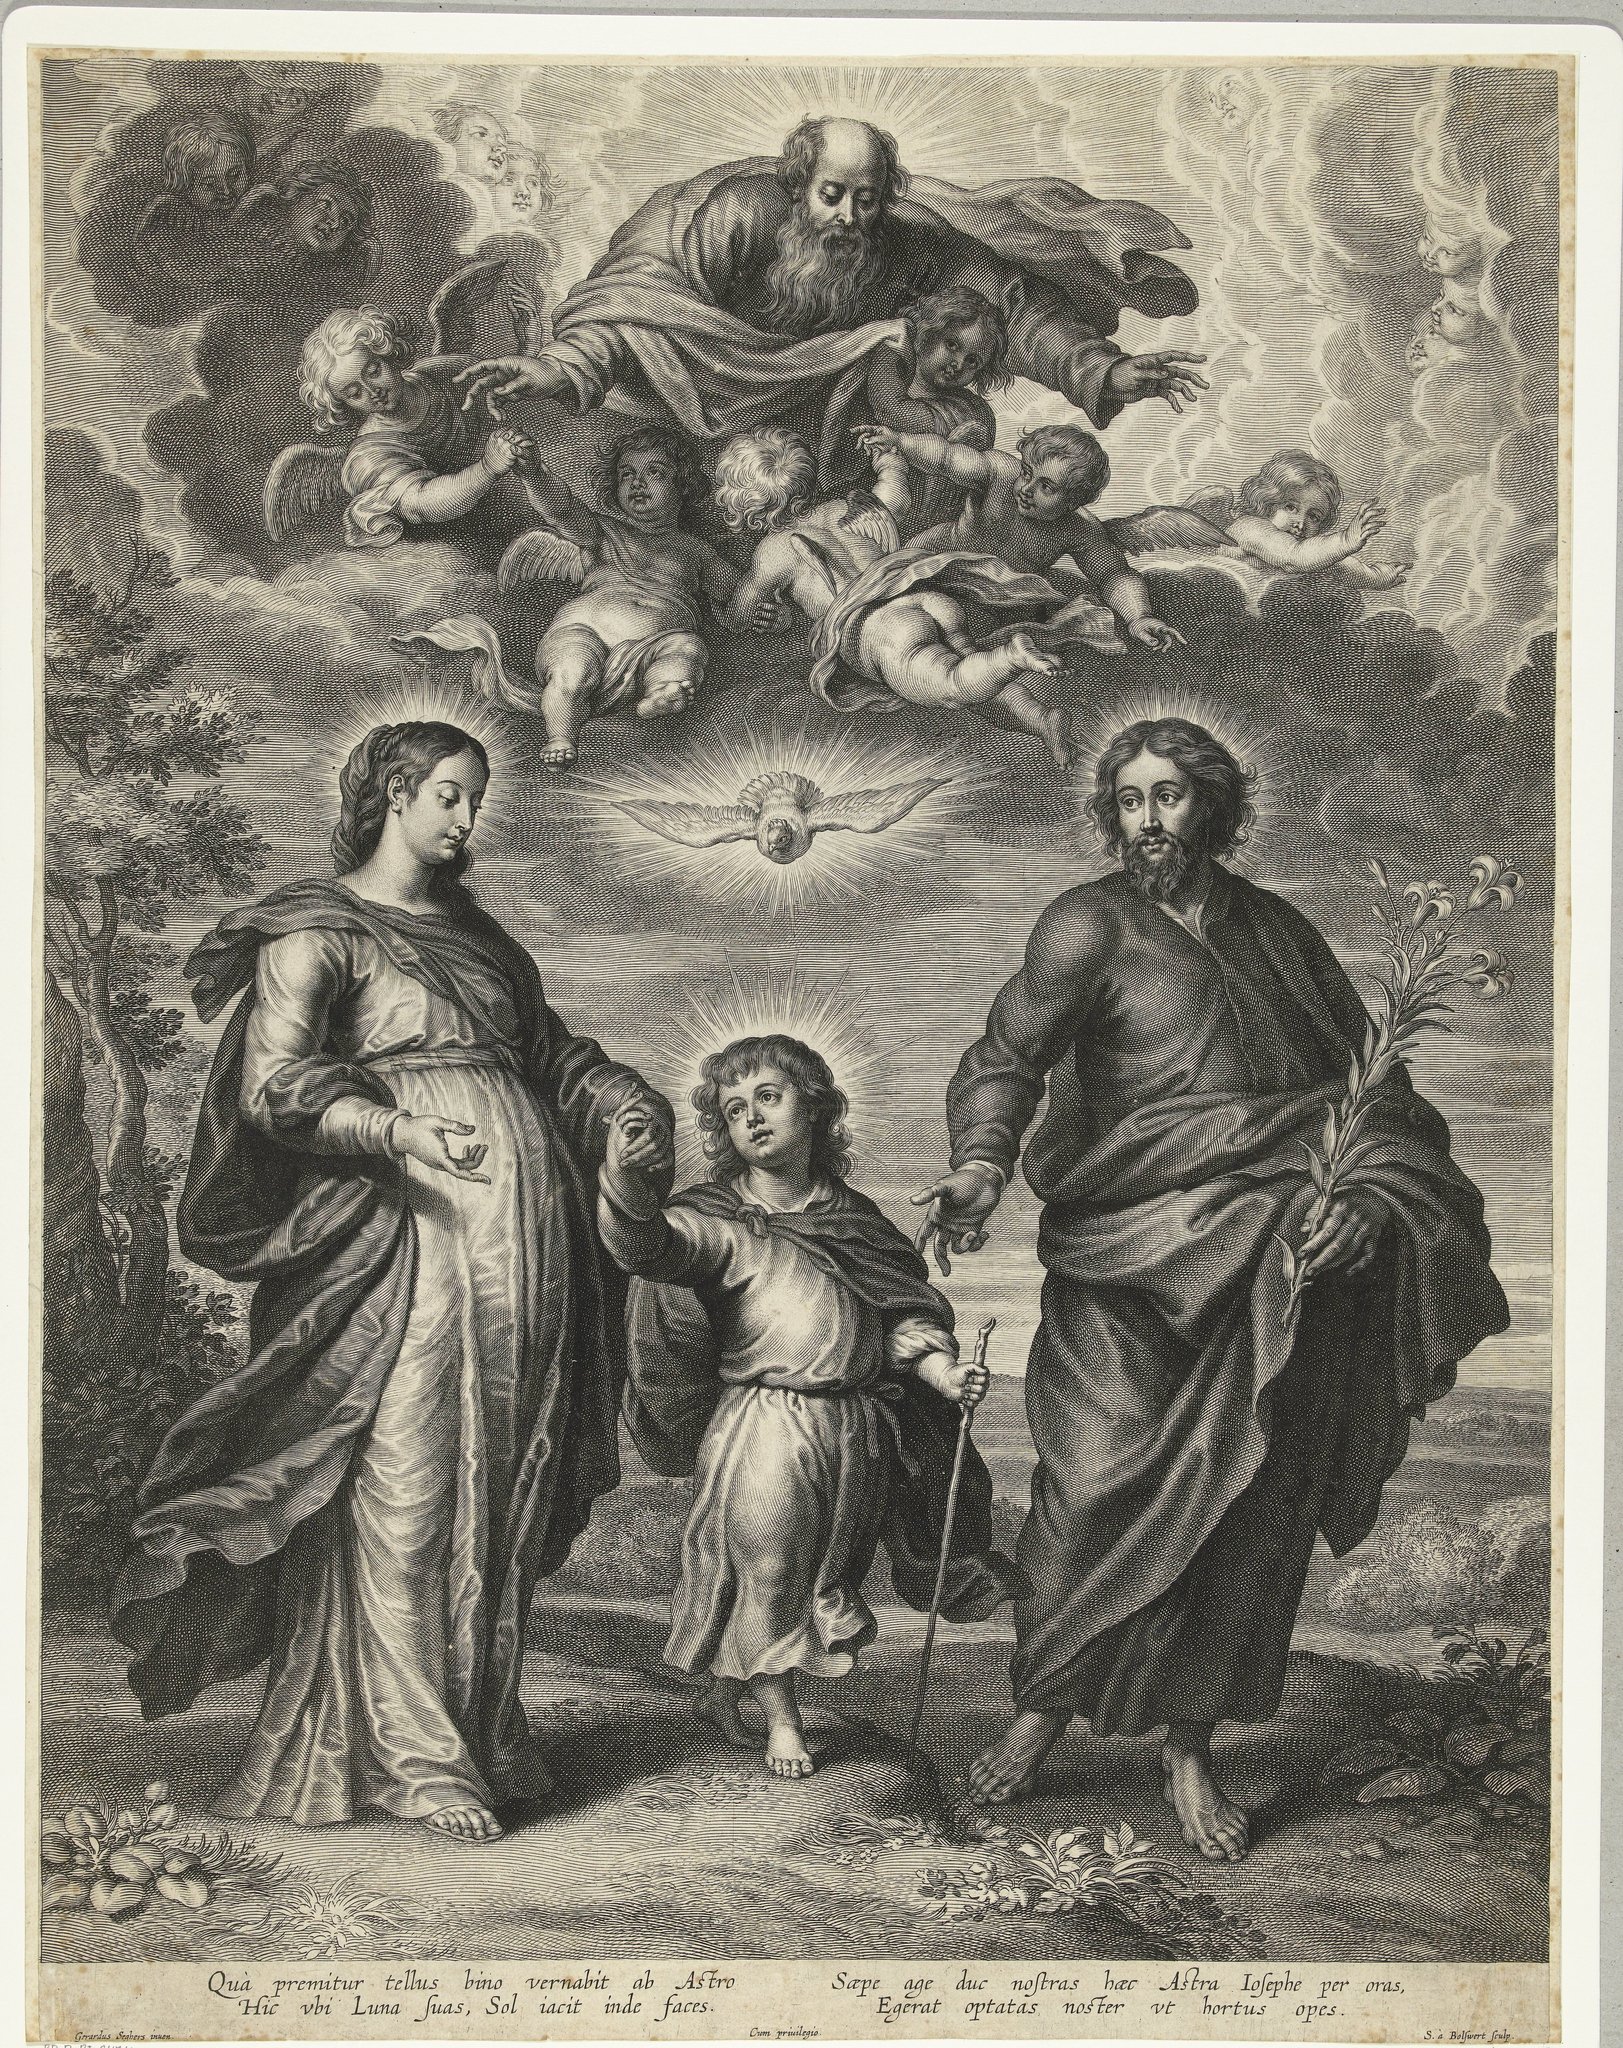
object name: print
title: Christuskind loopt tussen Maria en Jozef met boven hen God, Heilige Geest en engelen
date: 1596-1659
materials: paper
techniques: engraving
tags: holy family, and derived representations, holy trinity in which one, two or all figures are represented in human shape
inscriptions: collector's mark: Lugt 240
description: Het Christuskind loopt aan de hand van Maria naast Jozef met boven hen God omringd door engelen en de duif als symbool van de Heilige Geest, samen met Christus vormen zij de Heilige Drieëenheid. Onder de voorstelling staat een Latijns vers.